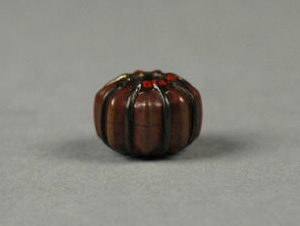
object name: ojime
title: Ojime in the Shape of a Melon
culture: japanese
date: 1801-1900